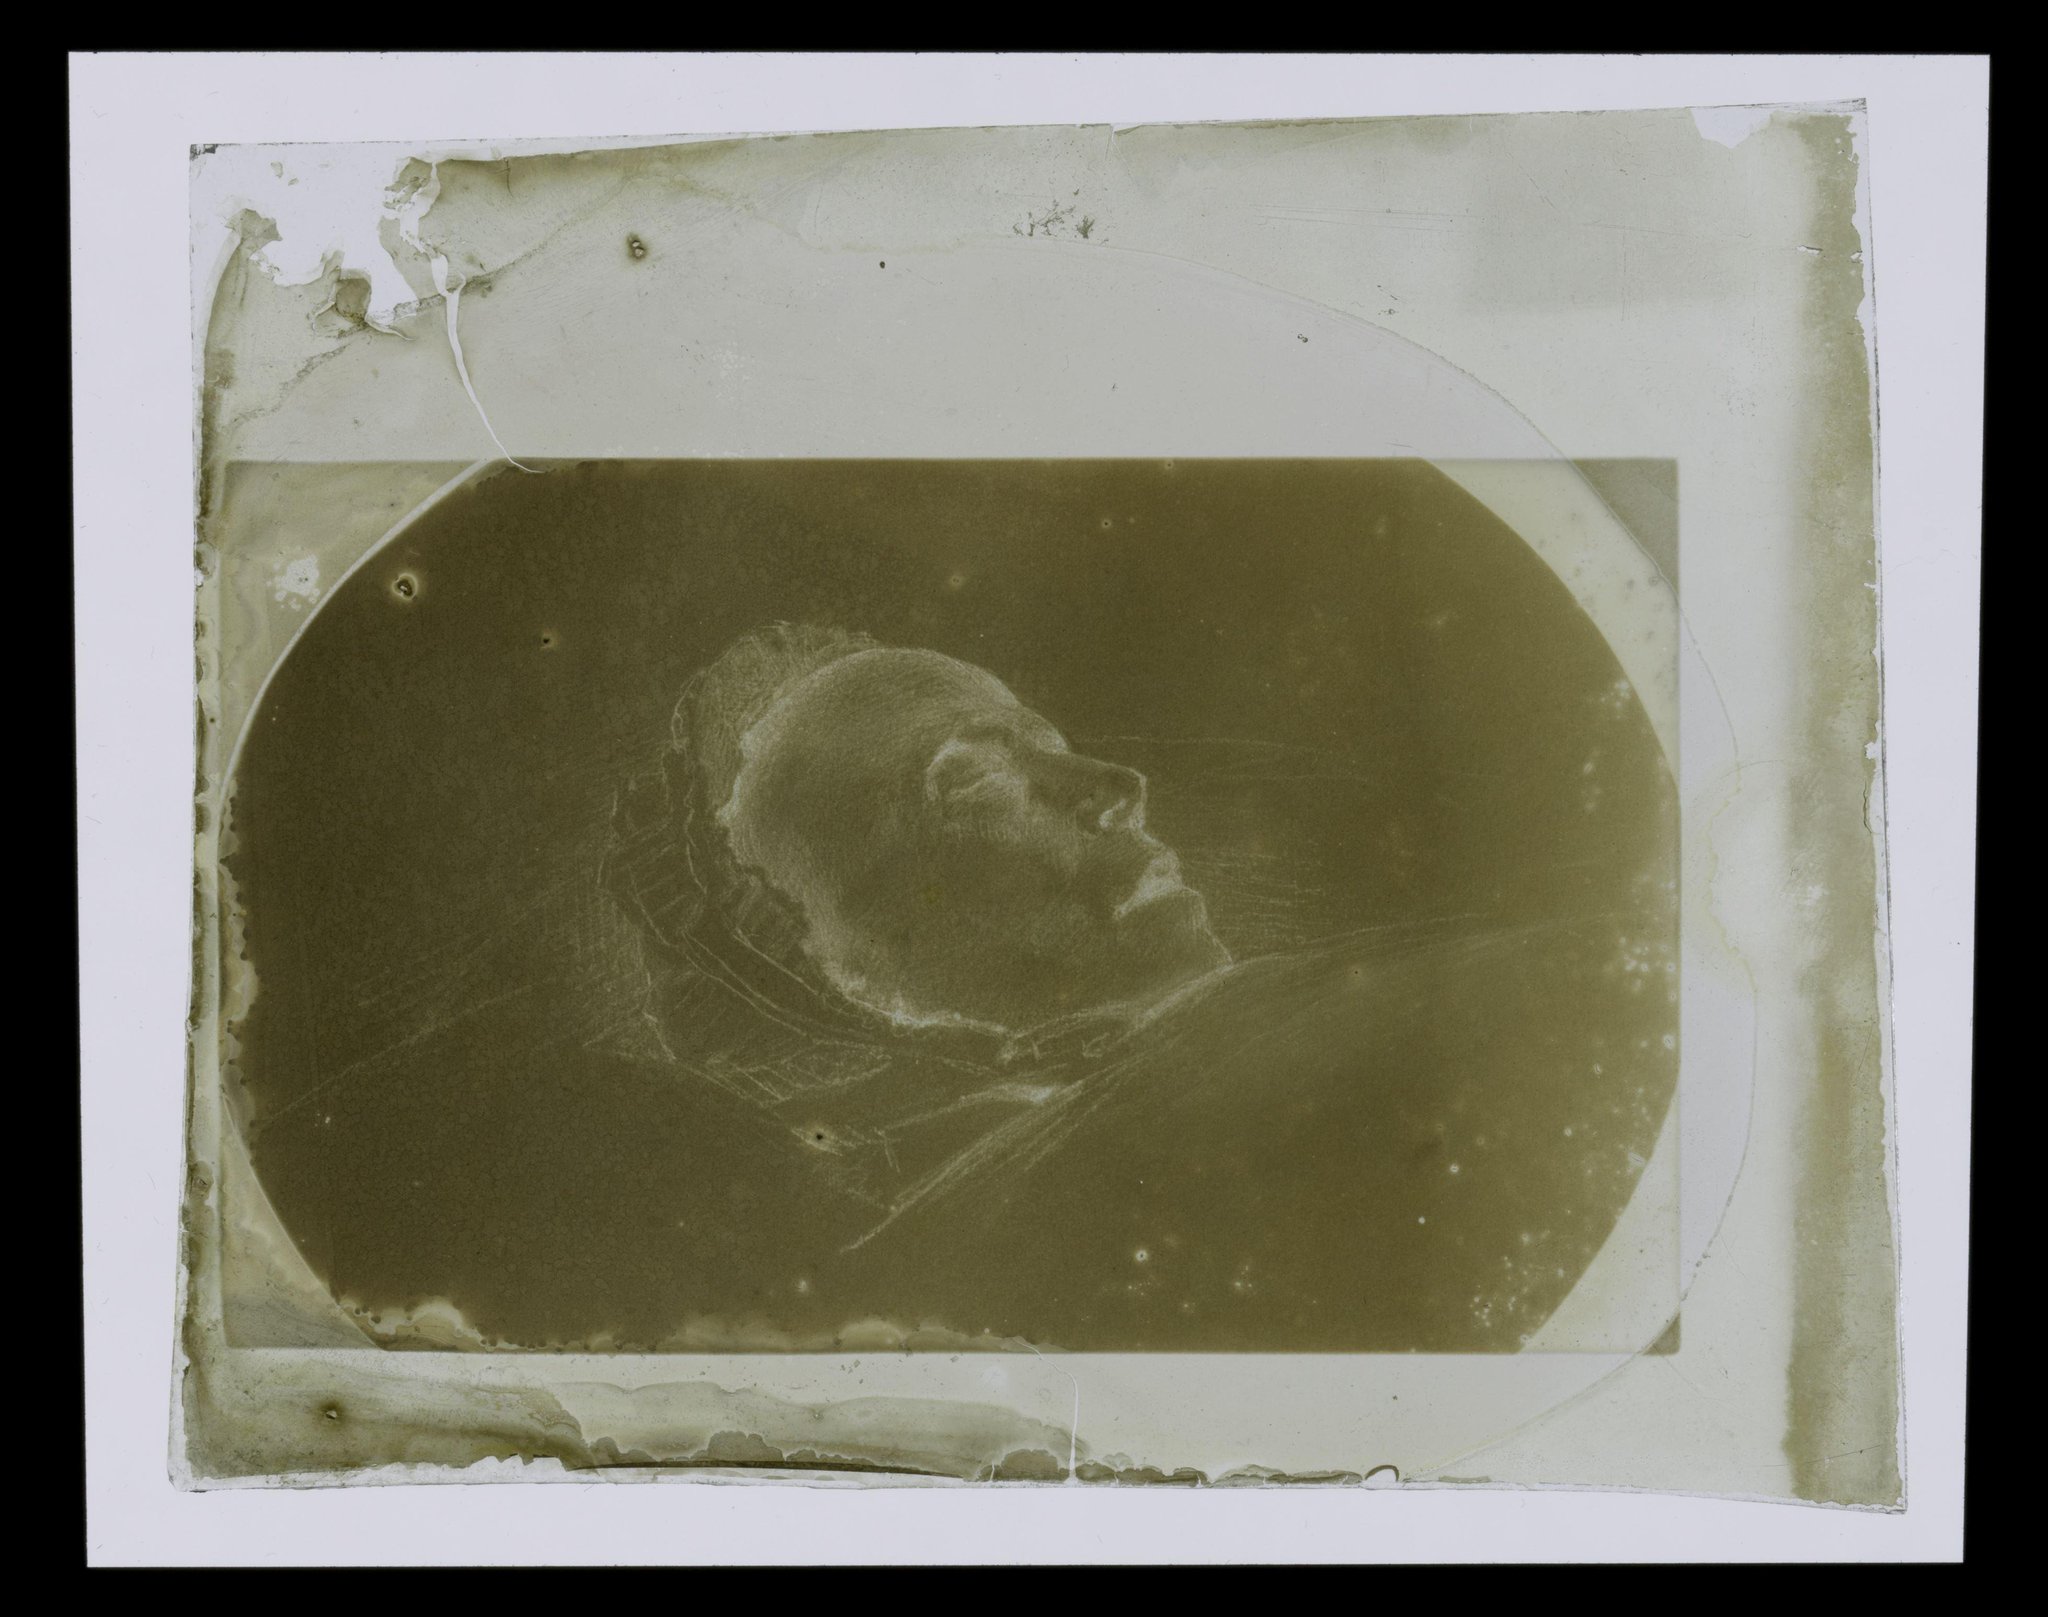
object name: glasnegatief, glasplaatnegatief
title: Fotoreproductie van een getekend post-mortem portret van een onbekende vrouw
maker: laurens lodewijk kleijn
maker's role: draughtsman, painter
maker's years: 1826-1909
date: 1865-1900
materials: glass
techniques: collodion process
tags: anonymous historical person portrayed - bb - woman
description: Onderdeel van een groep glasnegatieven uit de nalatenschap van de schilder Laurens Lodewijk Kleijn, met stillevens, portretten, zelfportretten en kunstreproducties.